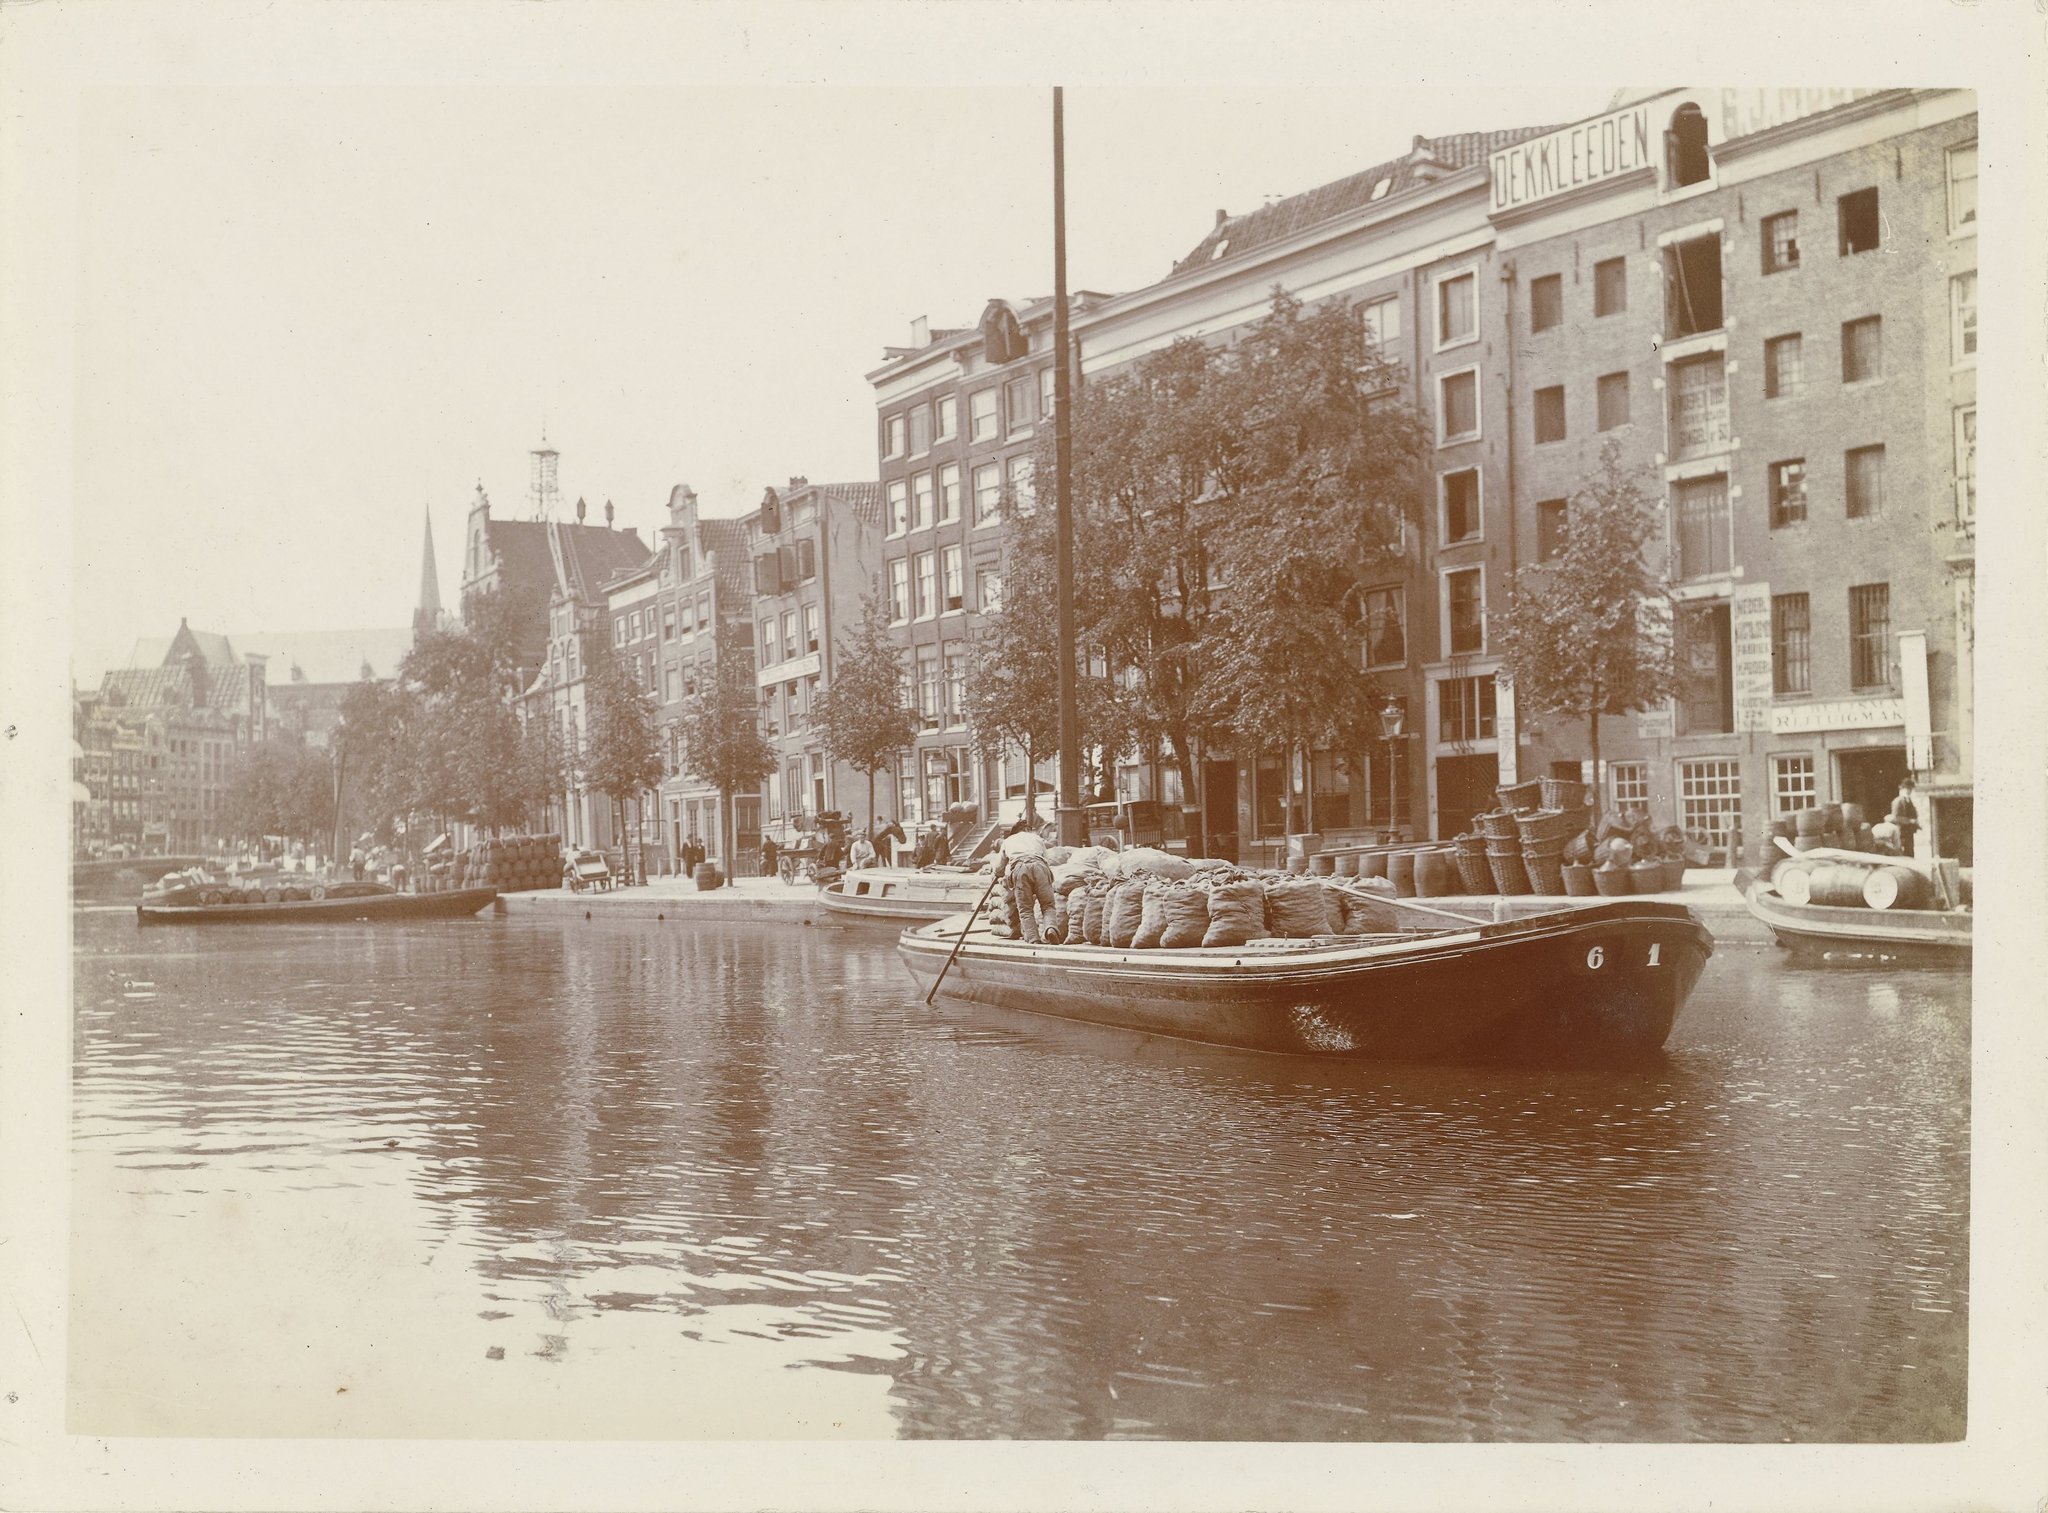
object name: photograph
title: Gezicht op het Singel in Amsterdam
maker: james higson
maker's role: politician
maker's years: 1862-1933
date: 1904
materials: paper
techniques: gelatin silver print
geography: amsterdam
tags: canals, waters (in city)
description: Gezicht op het Singel in de richting van de Krijtberg, op het water een schuit geladen met zakken.